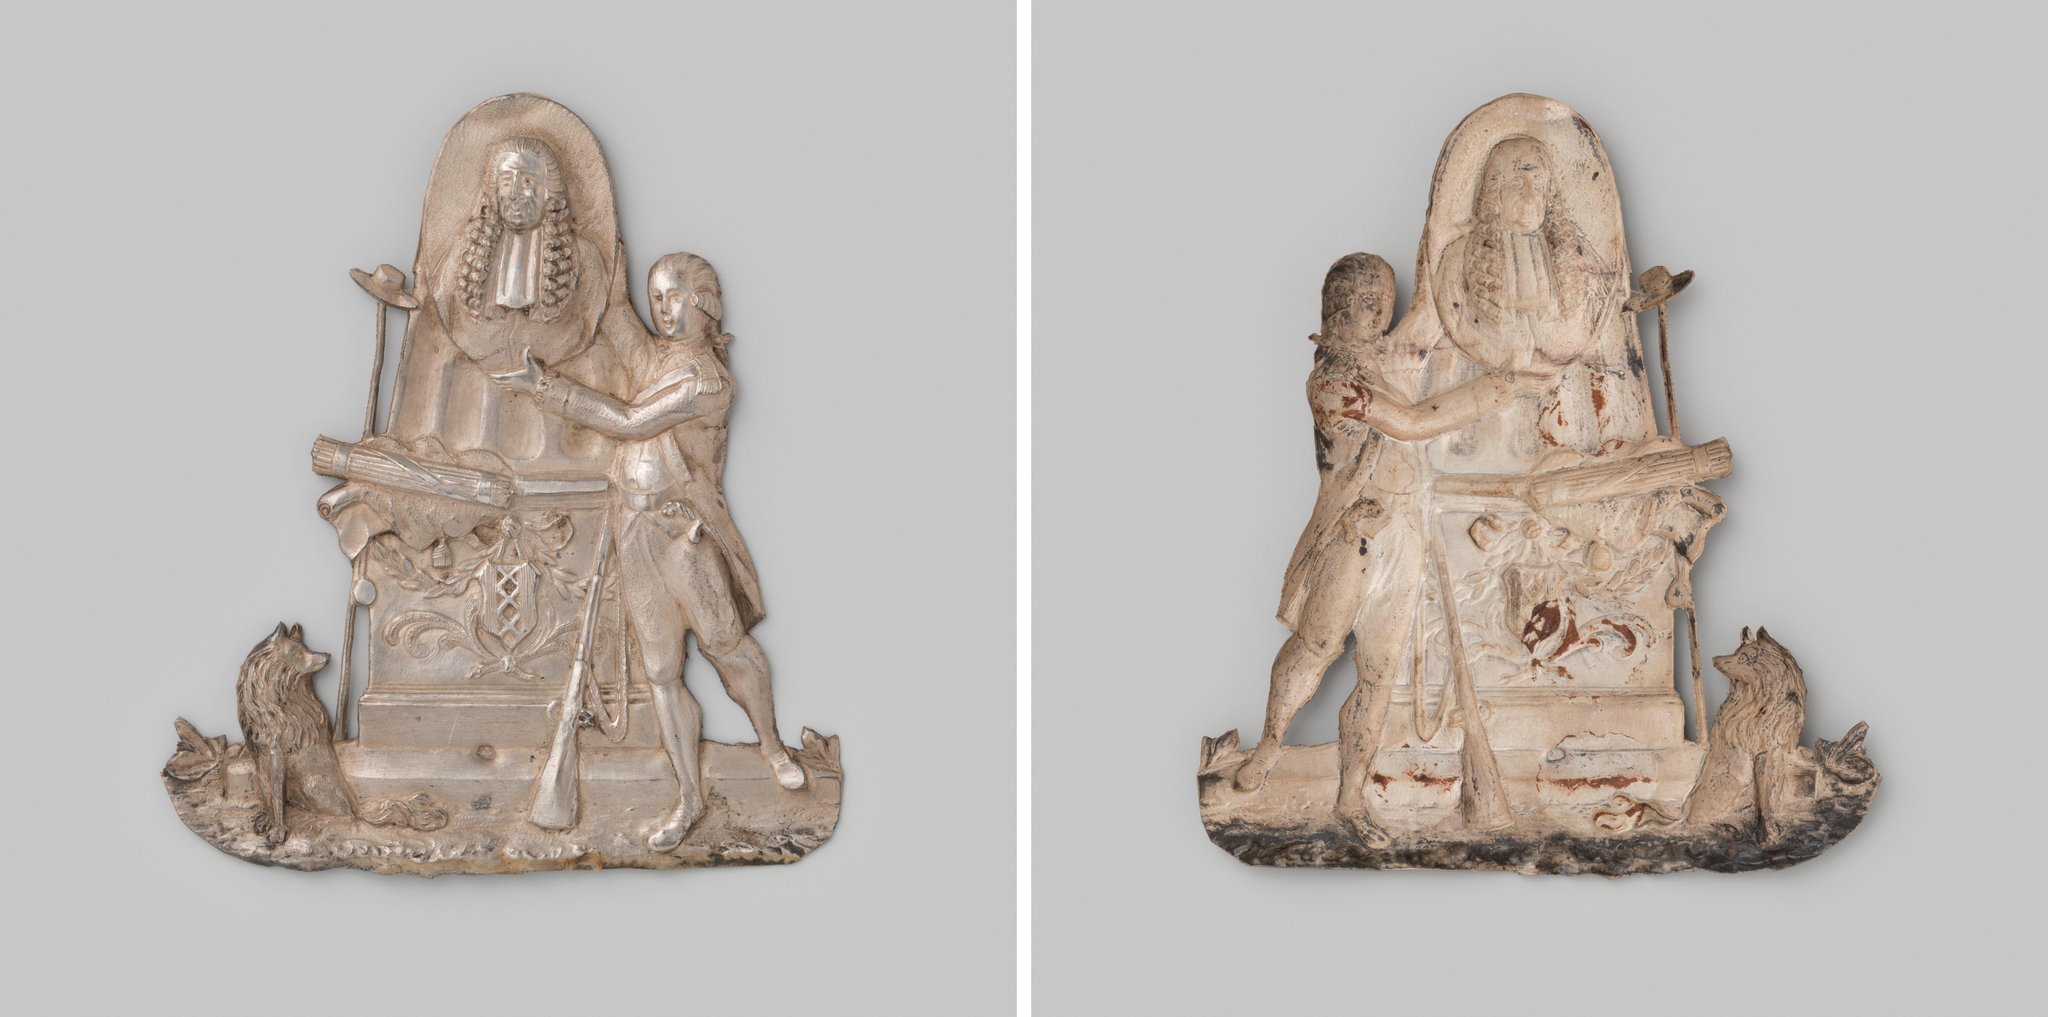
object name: plaque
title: Hendrik Danielsz Hooft, burgemeester van Amsterdam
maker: Anonymous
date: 1787-1794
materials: silver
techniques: repoussé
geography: netherlands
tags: amsterdam, mayor, hendrik danielsz. hooft